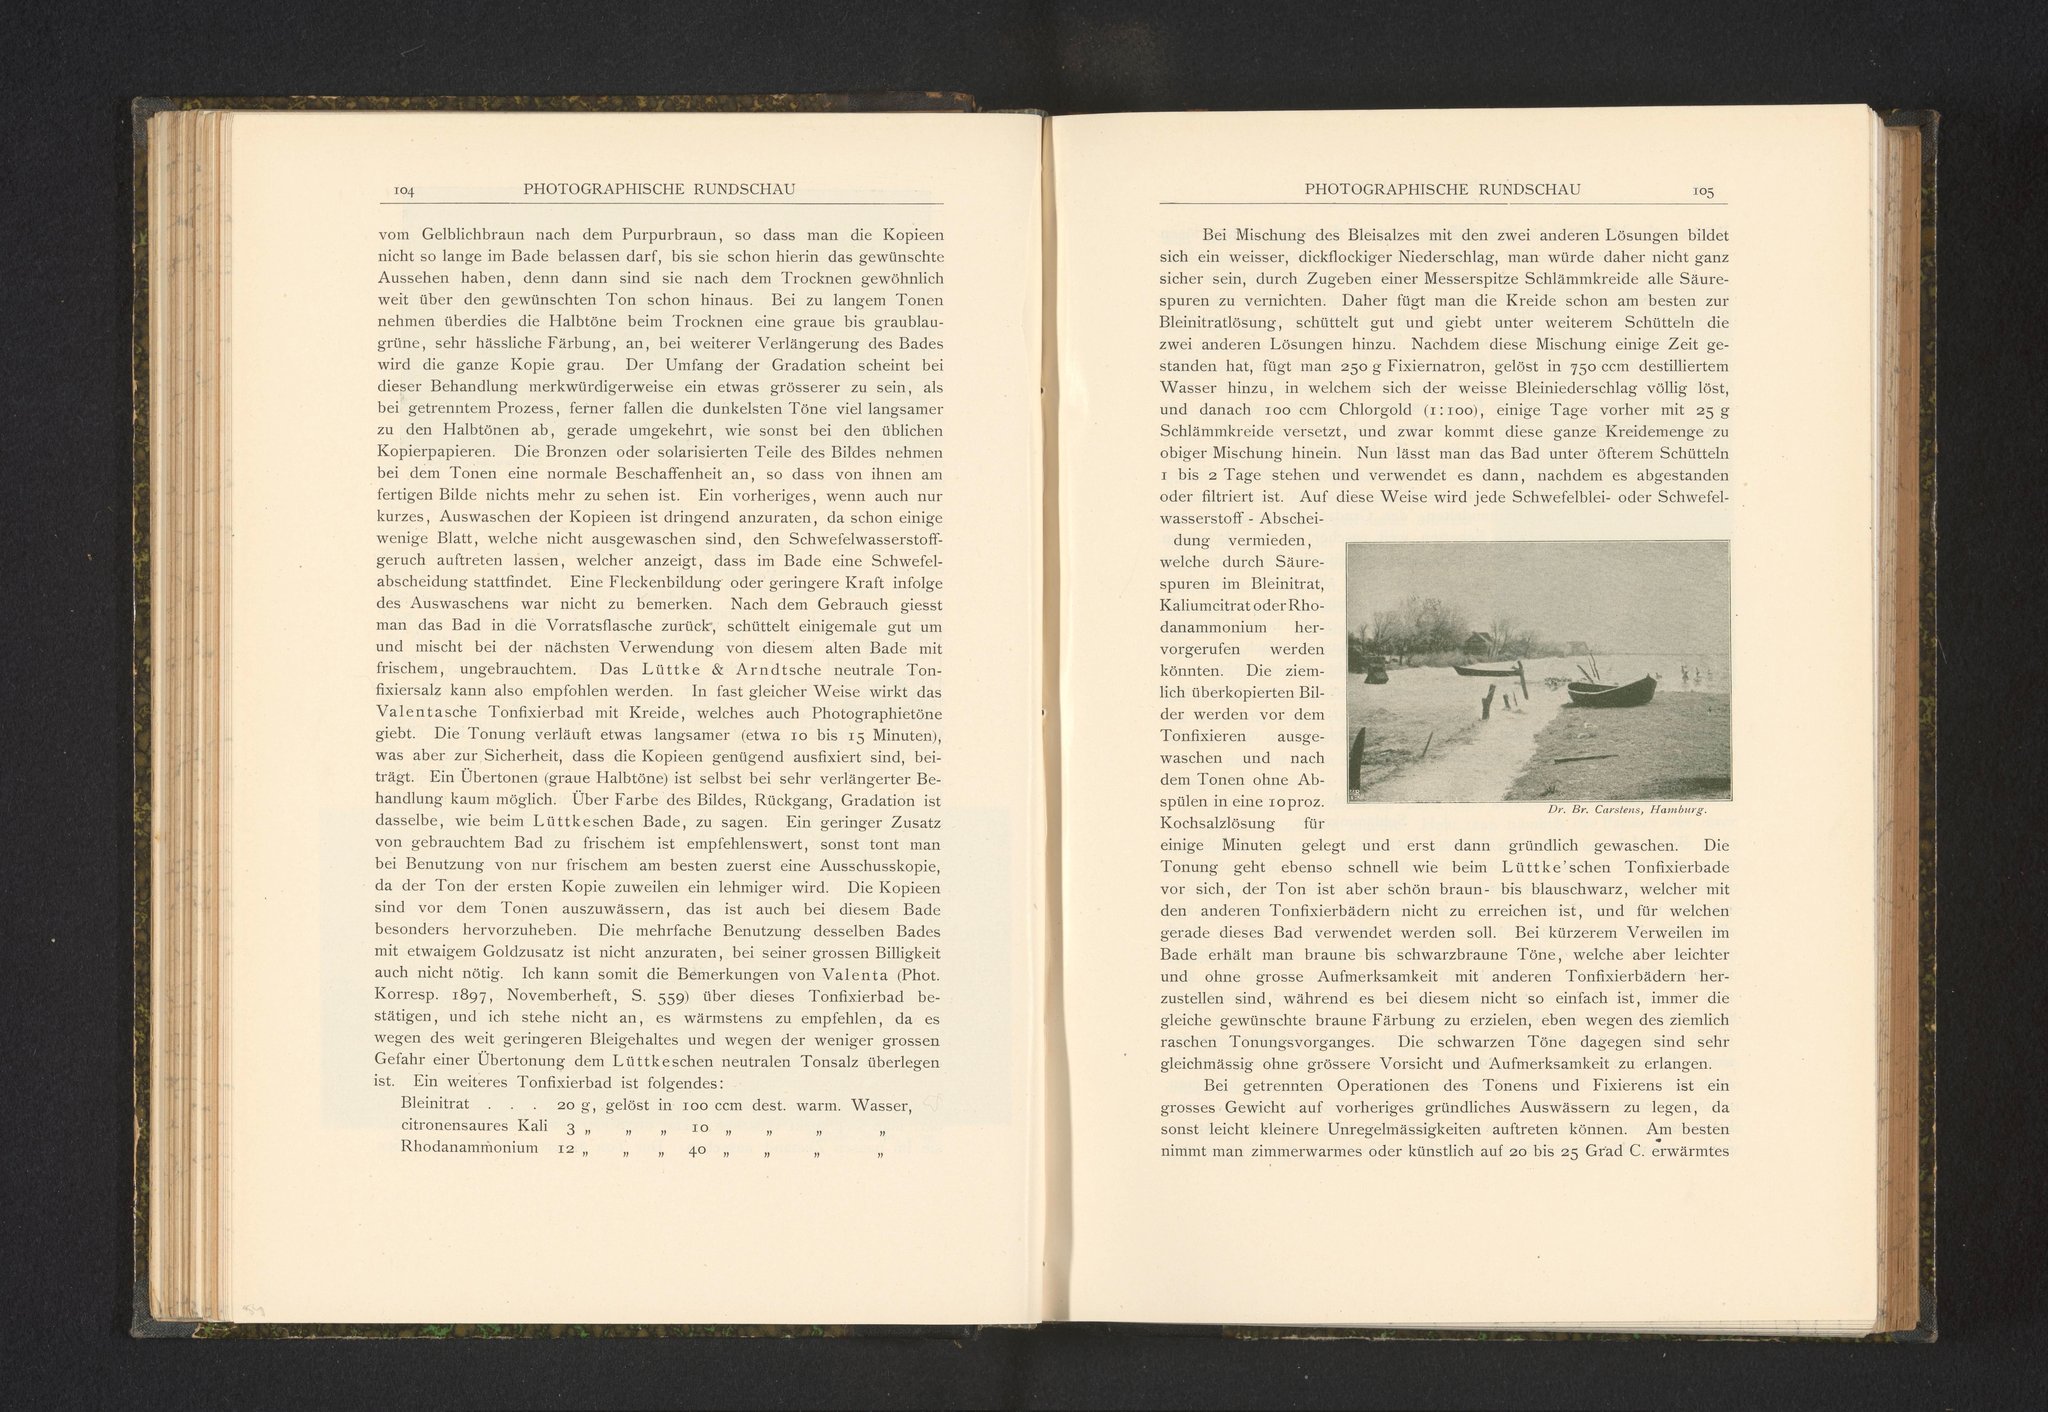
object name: photomechanical print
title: Gezicht op een bevroren rivier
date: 1893-1898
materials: paper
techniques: autotype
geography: hamburg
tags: river, ice ~ state of water